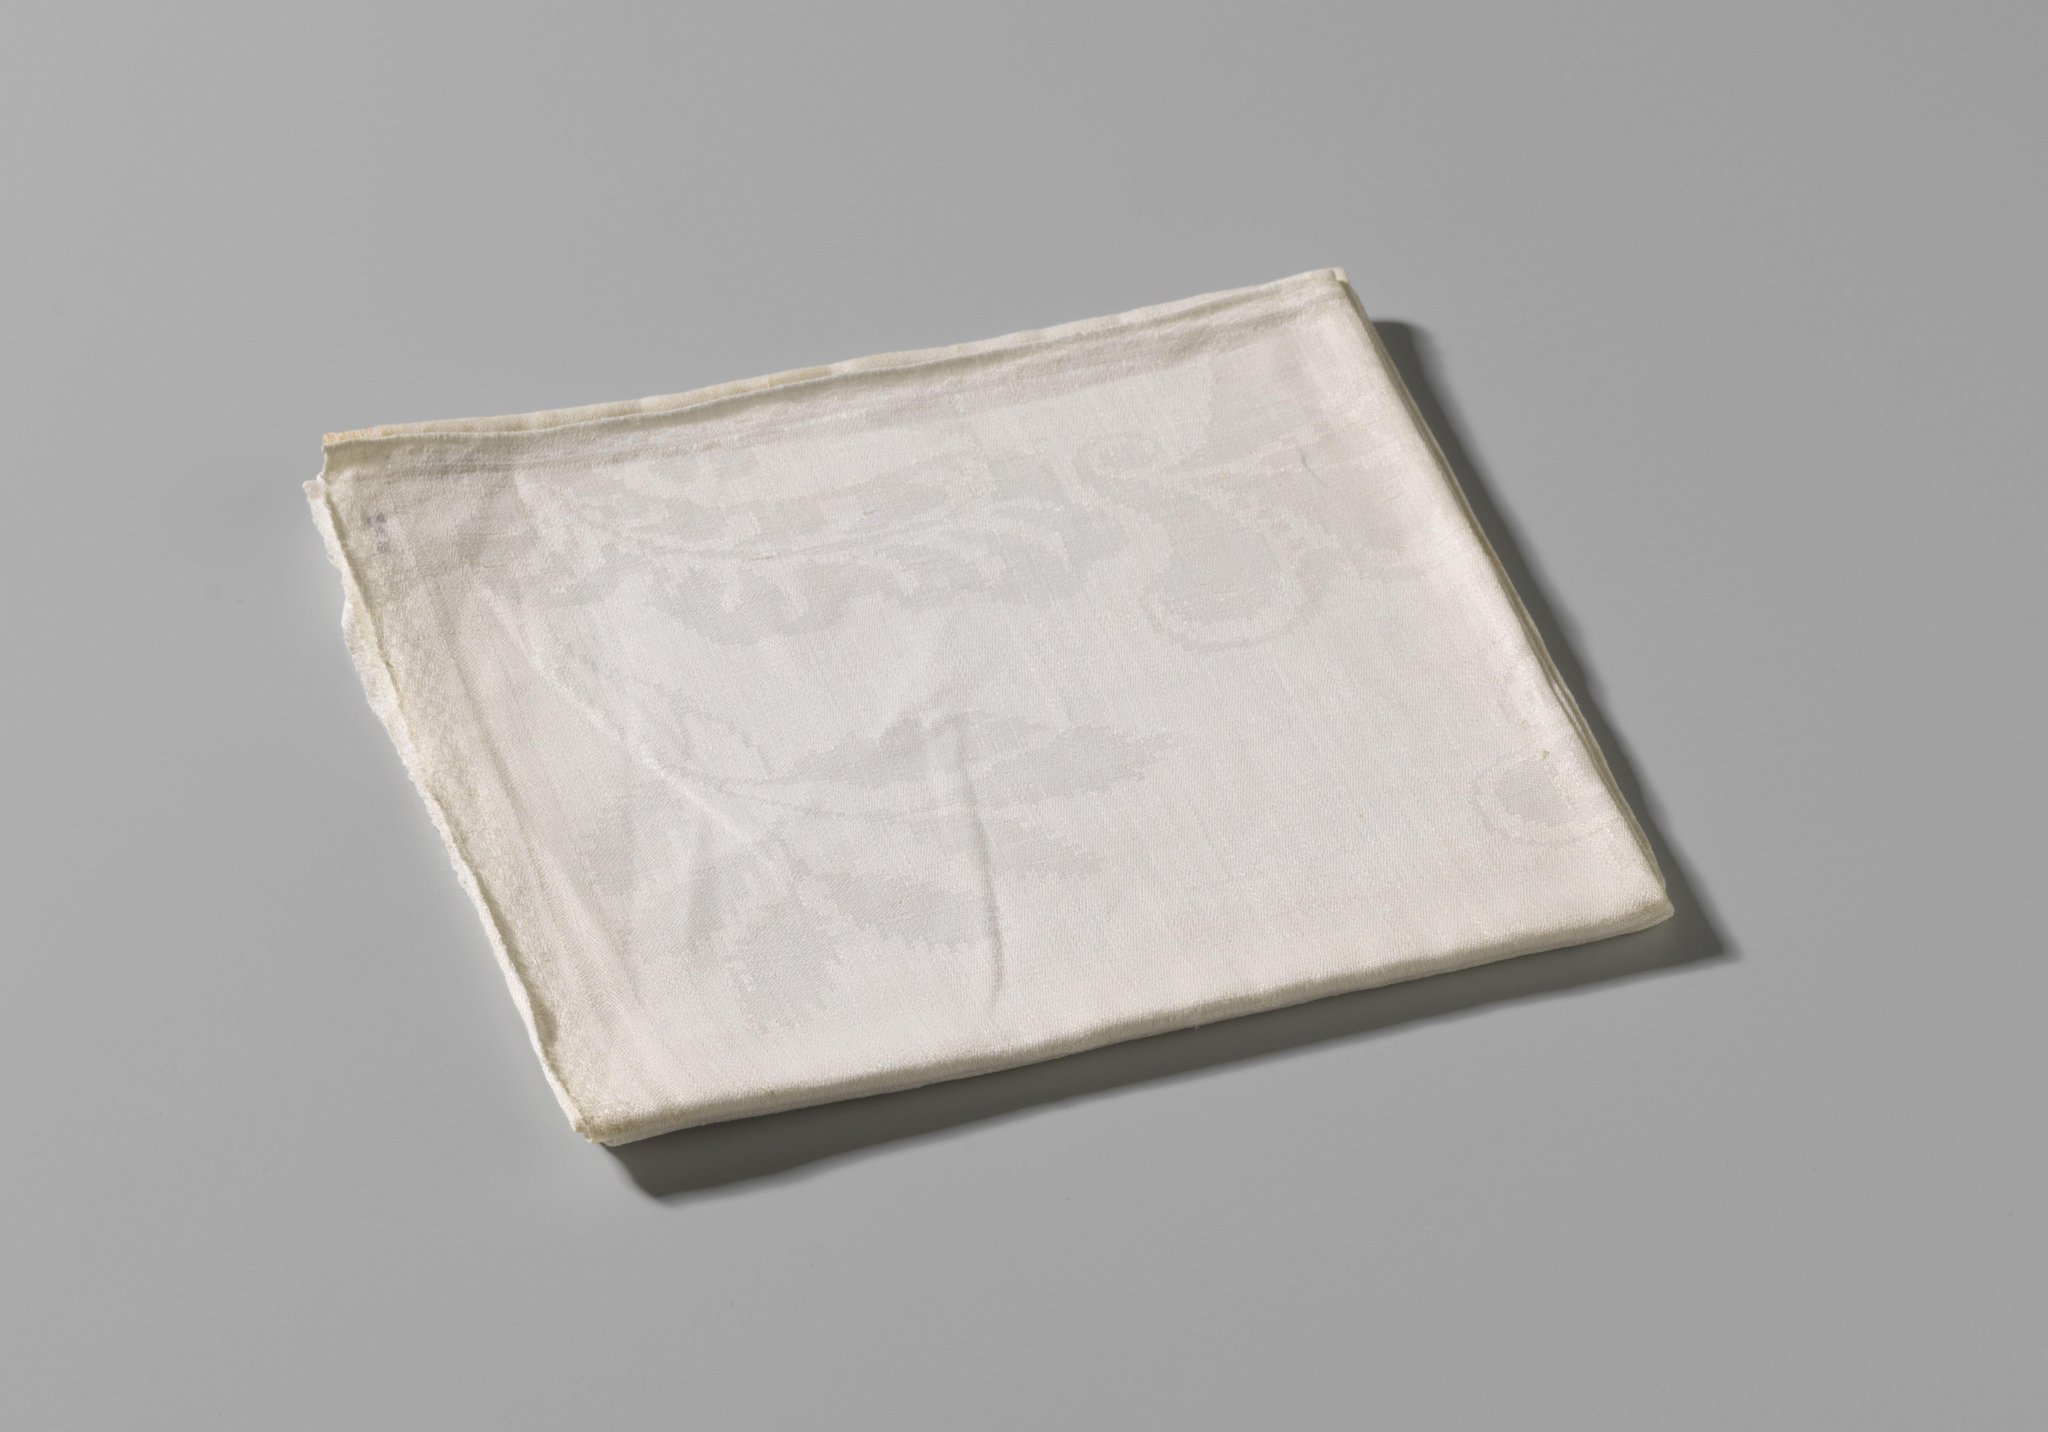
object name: napkin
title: servet van linnendamast met dessin van bloemenvaas waaromheen bandwerk met kantpatroon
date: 1725-1750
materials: linen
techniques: damask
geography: southern netherlands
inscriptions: mark: ‘no5?’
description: Servet van wit linnendamast met een dessin van bloemenvaas waaromheen bandwerk met kantpatroon. Zuidelijke Nederlanden (?)m 2de kwart 18de eeuw.